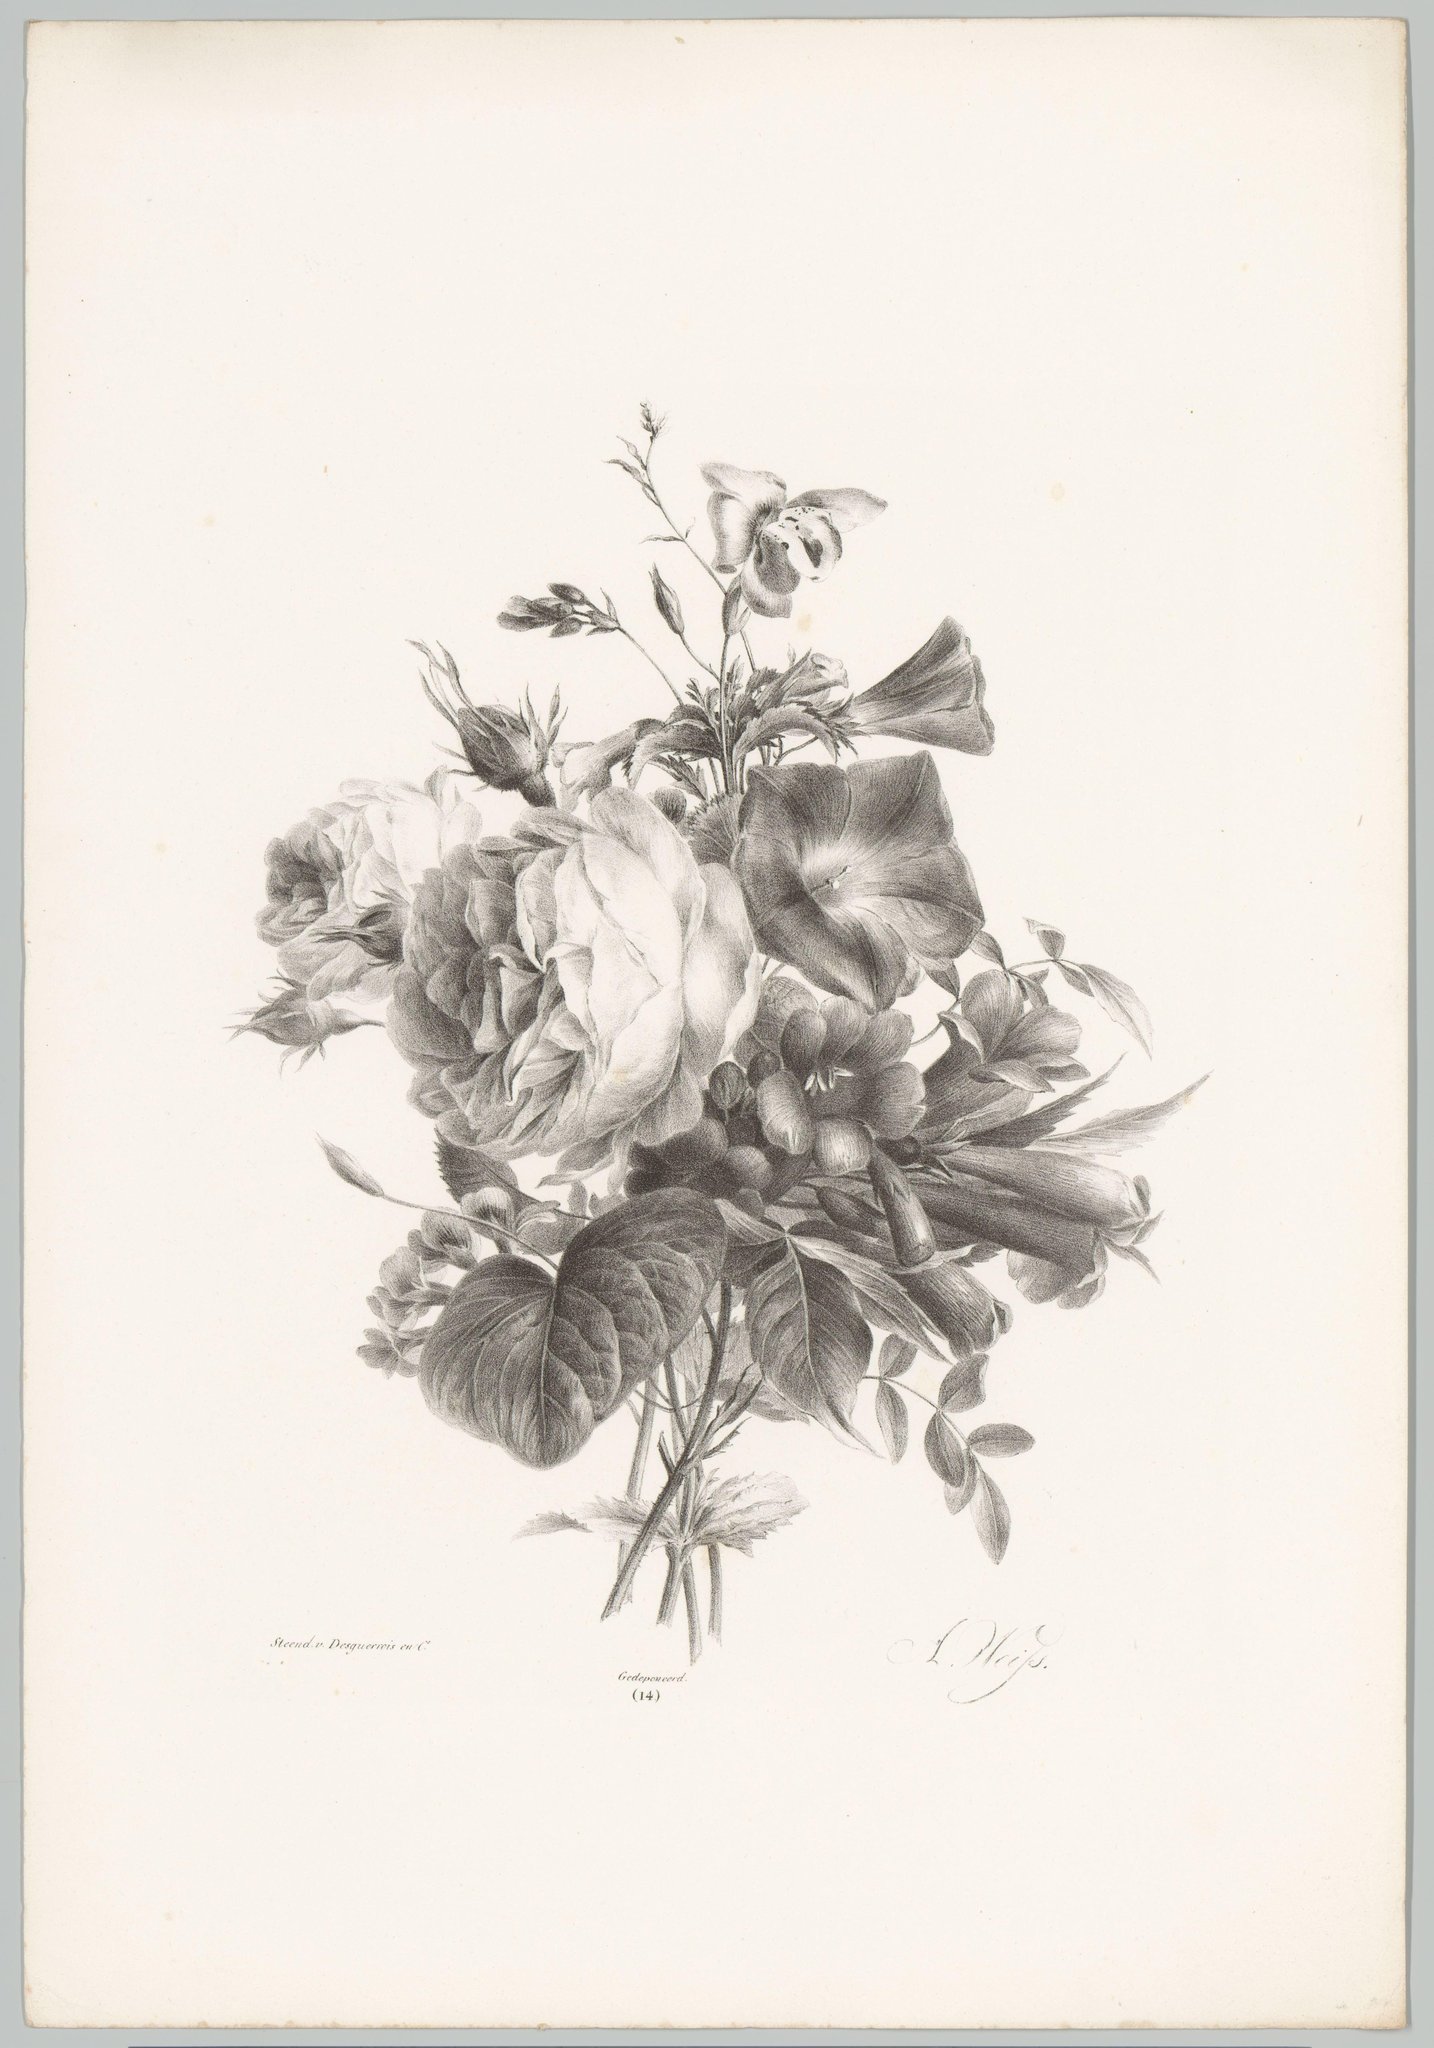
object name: print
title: Bloem en Fruit Studien (...) 10e aflevering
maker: anton weiss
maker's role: draughtsman, print maker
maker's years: 1801-1851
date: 1836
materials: paper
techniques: lithograph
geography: amsterdam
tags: flowers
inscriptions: : ‘Gedeponeerd.’, collector's mark: Lugt 2228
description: Onderdeel van een omslag met een serie van eenenveertig lithografieën van bloemen en fruit.